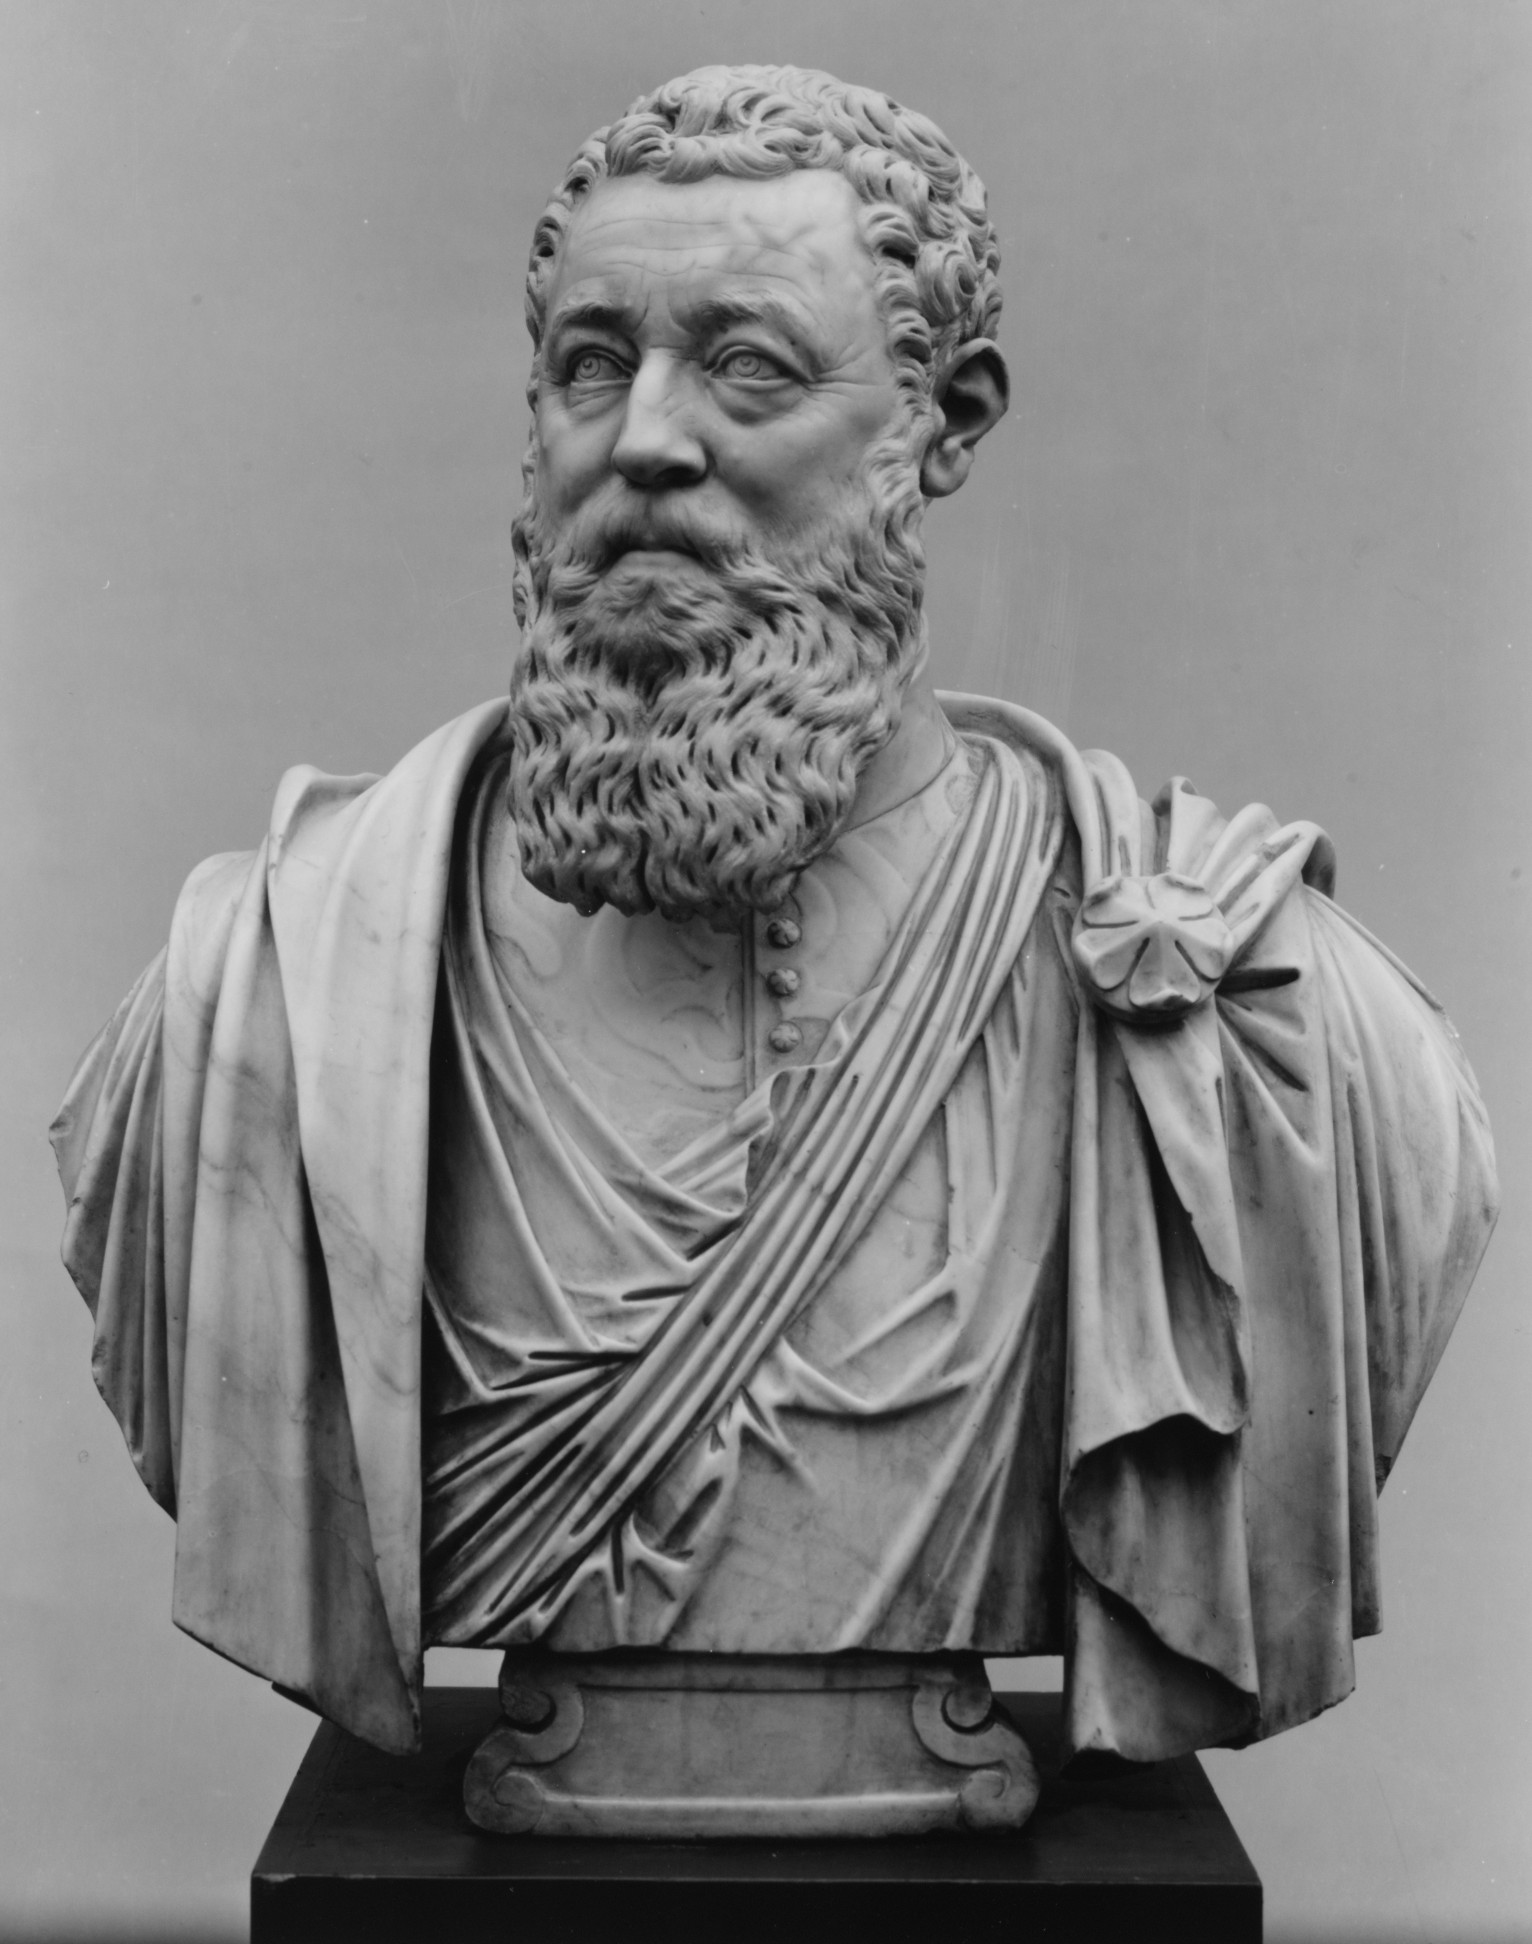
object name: bust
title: Francesco Bocchetta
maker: alessandro vittoria (alessandro vittoria di vigilio della volpa)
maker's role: artist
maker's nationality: italian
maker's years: 1525-1608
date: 1565-1590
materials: marble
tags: men,portraits